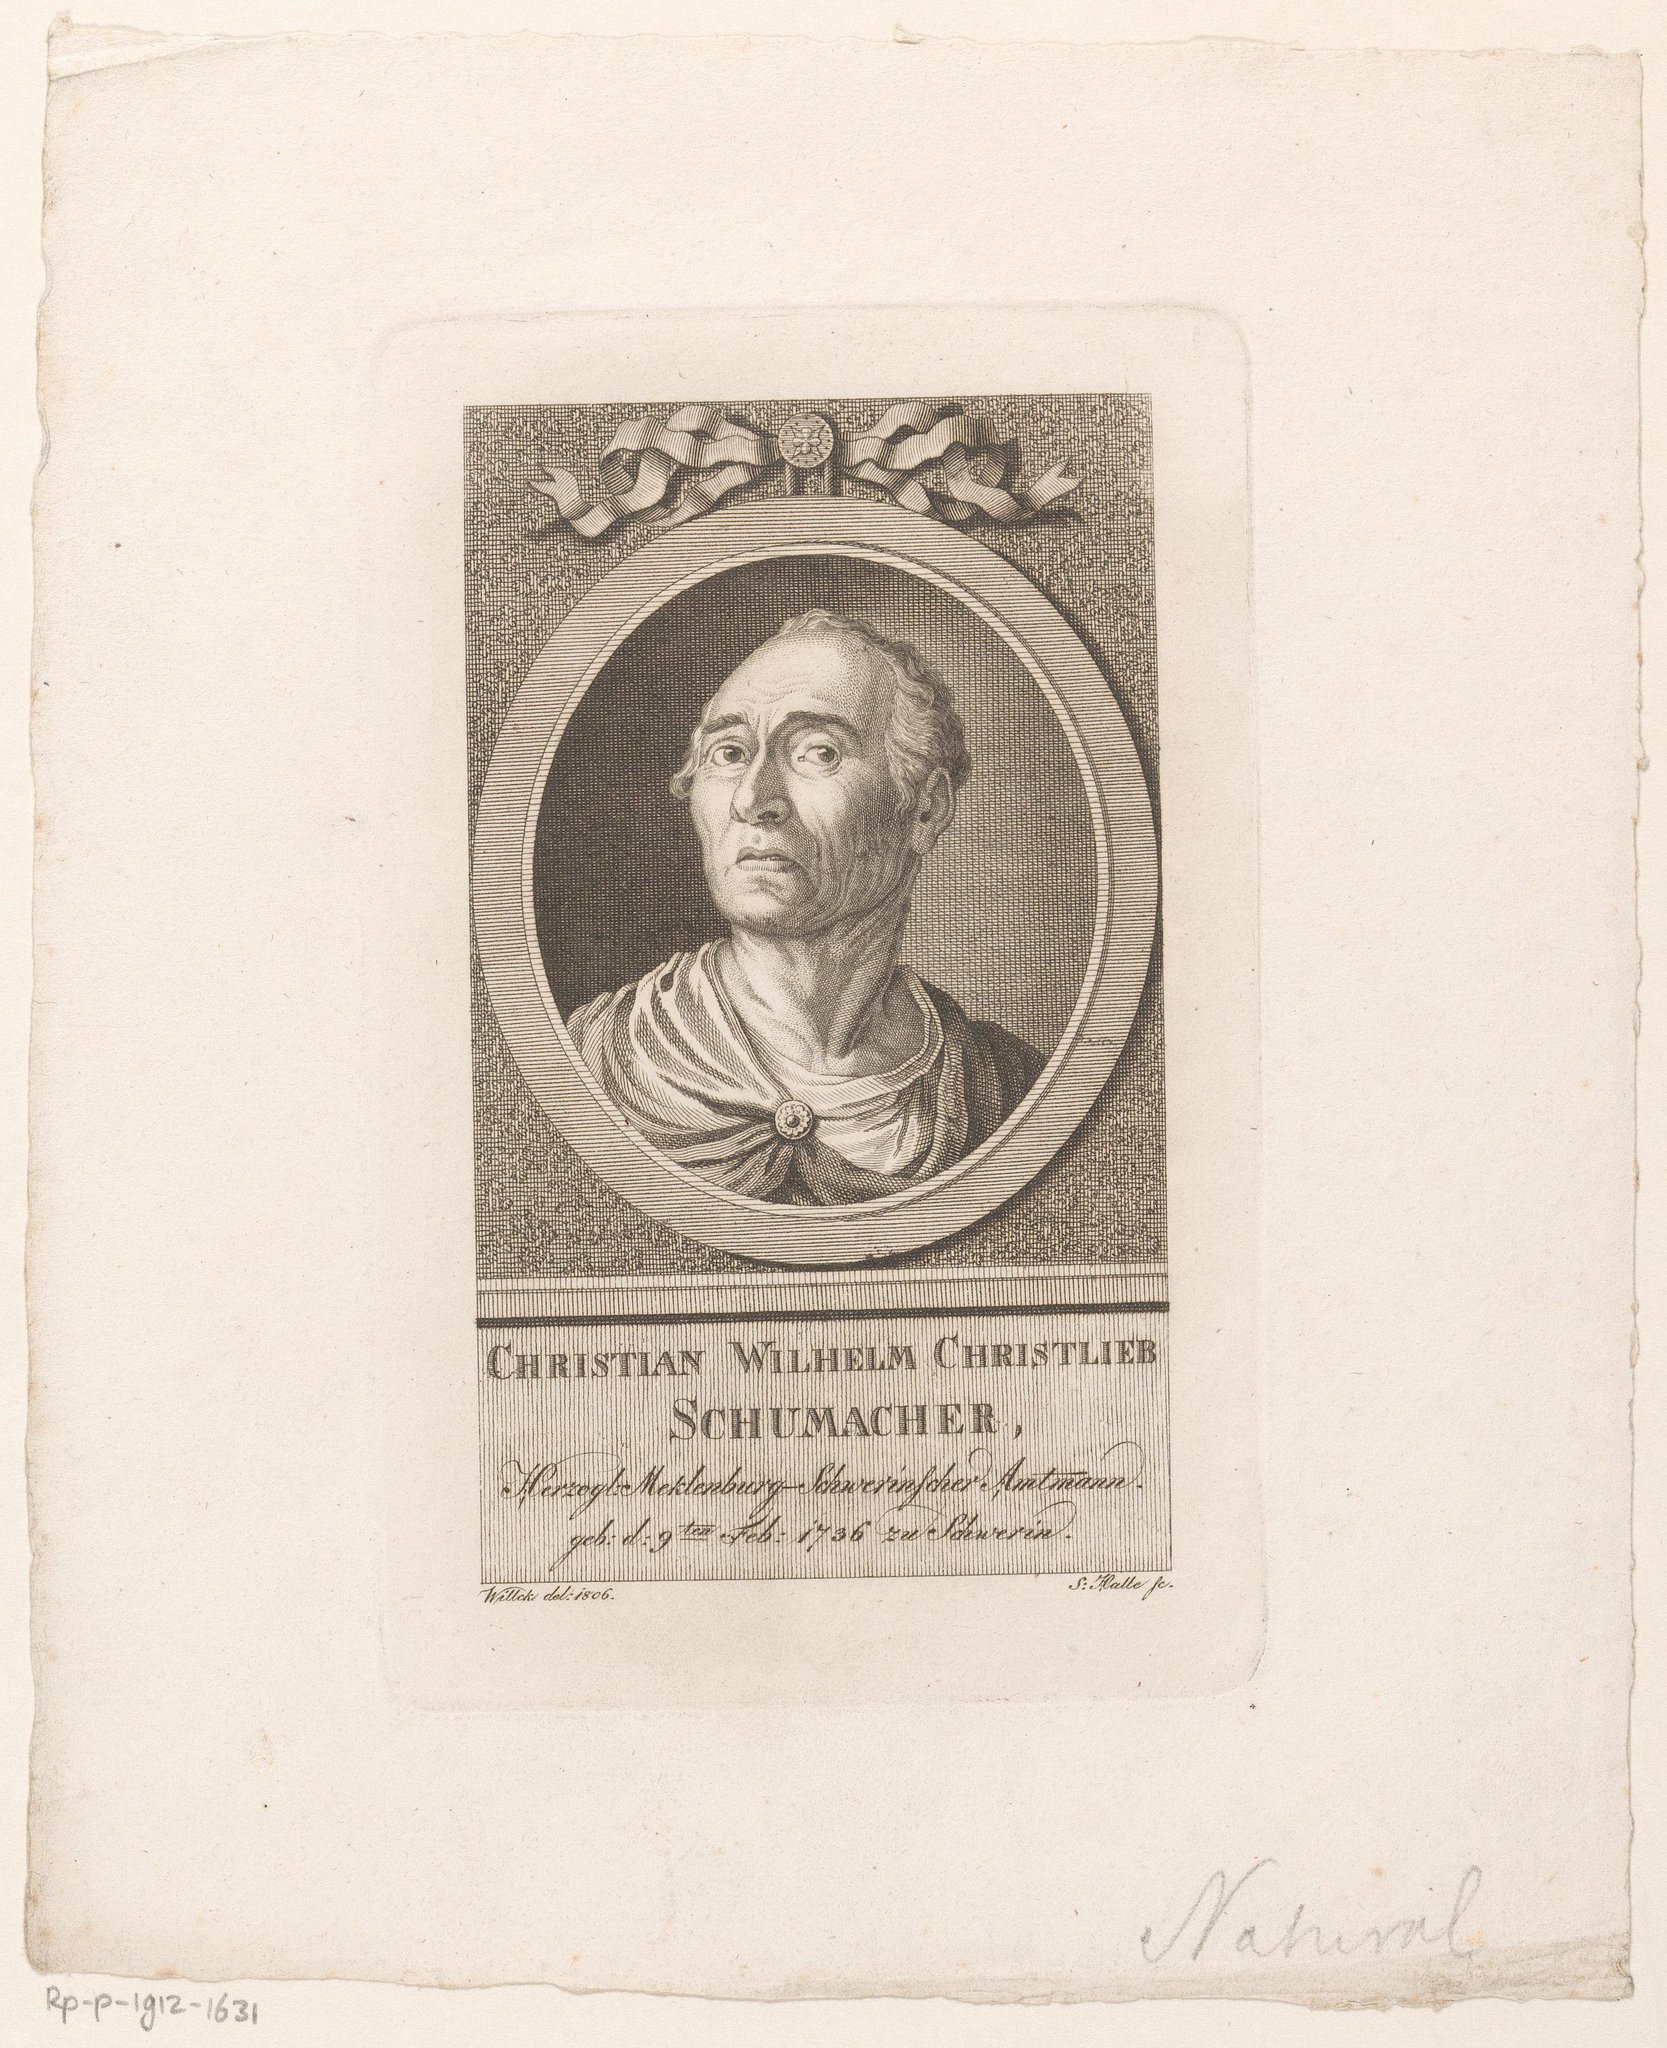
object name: print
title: Portret van Christian Wilhelm Christlieb Schumacher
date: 1750-1806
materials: paper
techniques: engraving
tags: ornament ~ medallion, historical persons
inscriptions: collector's mark: Lugt 2228